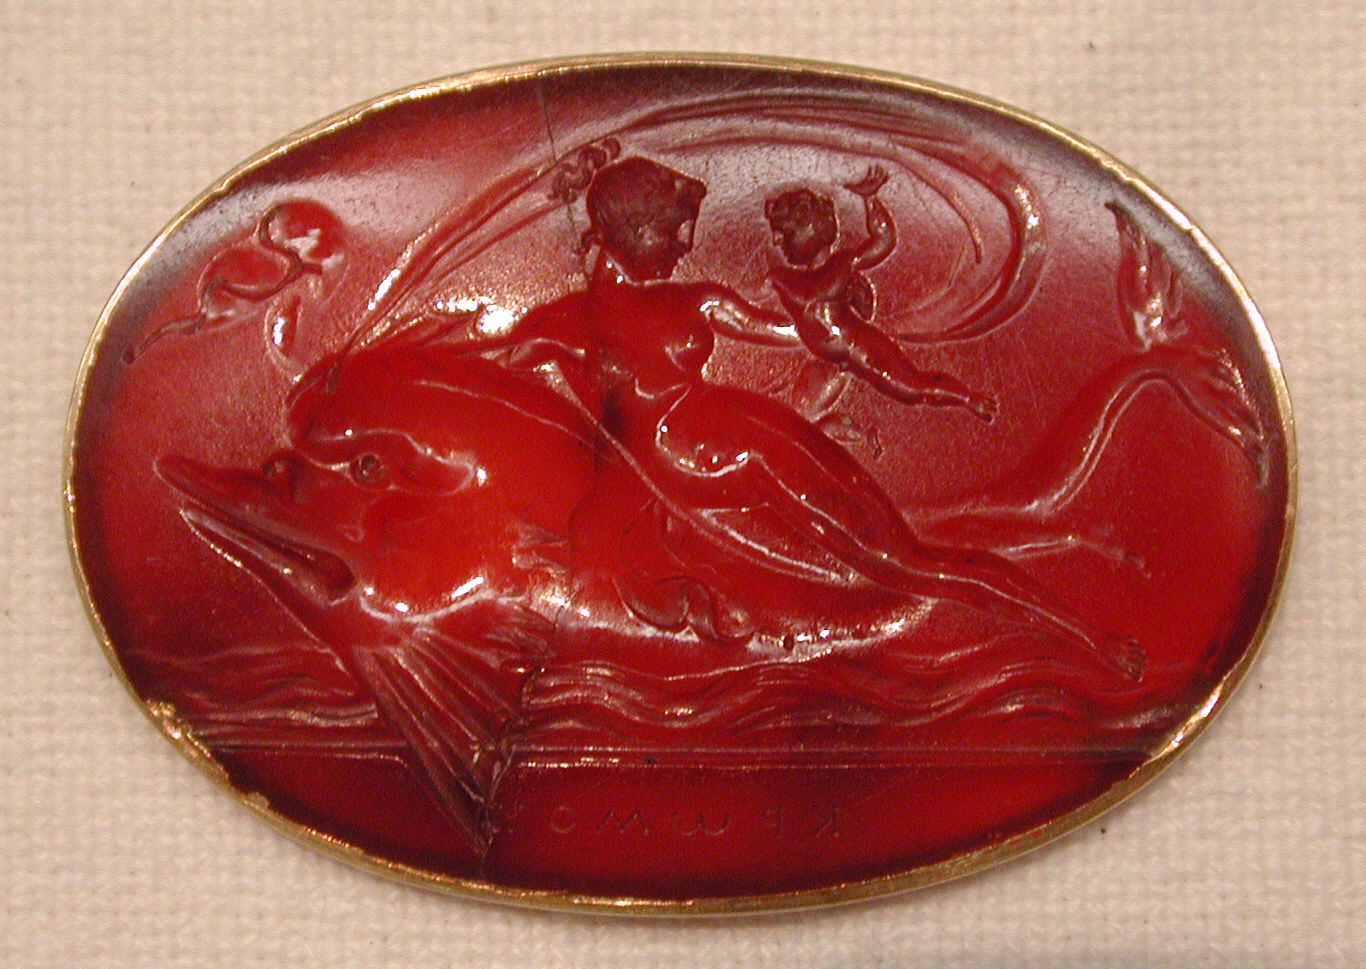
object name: intaglio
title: Ino with her infant Melicerta on the back of a dolphin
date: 1801-1833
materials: gemstone, gold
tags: infants,women,dolphins